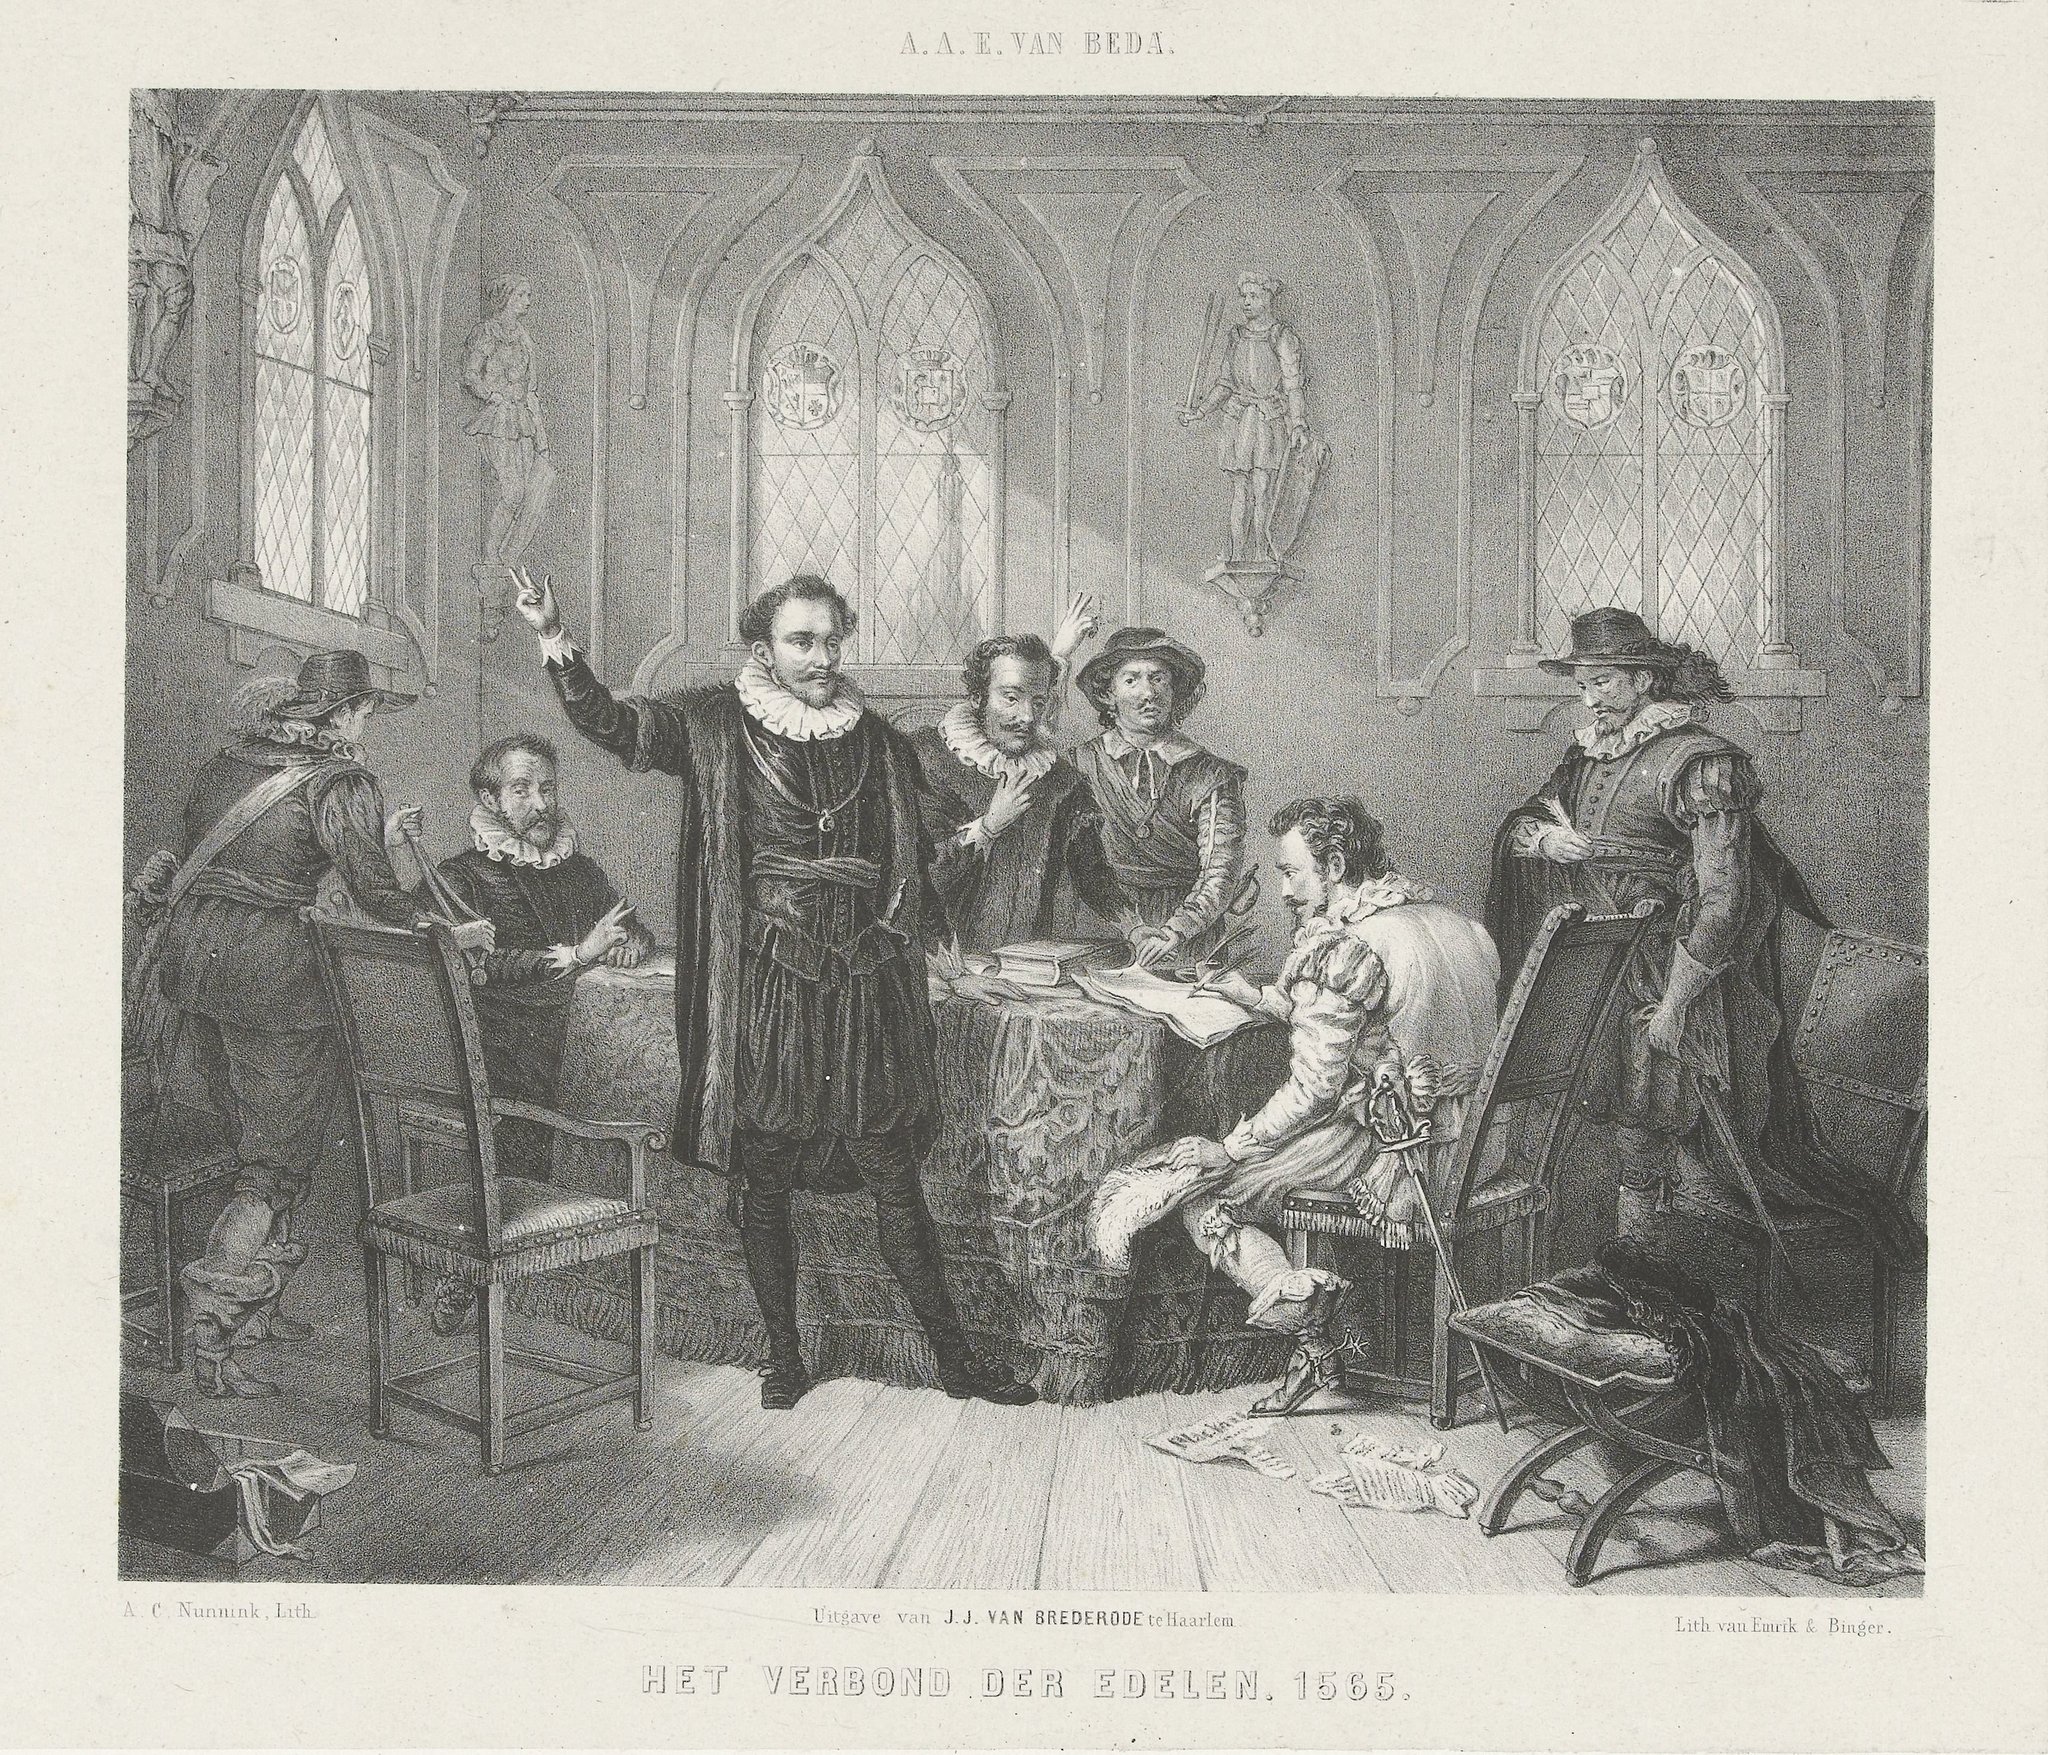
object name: history print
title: Het verbond der edelen, 1565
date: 1823-1894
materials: paper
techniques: lithograph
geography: netherlands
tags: swearing an oath (with two fingers raised), alliance, league, union, foedus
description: Het verbond der edelen op het kasteel van Hendrik van Brederode te Vianen, 1565. Enkele edelen verzameld rond een tafel waaraan een document wordt opgesteld. In het midden een staande man die met opgestoken hand een eed aflegt.